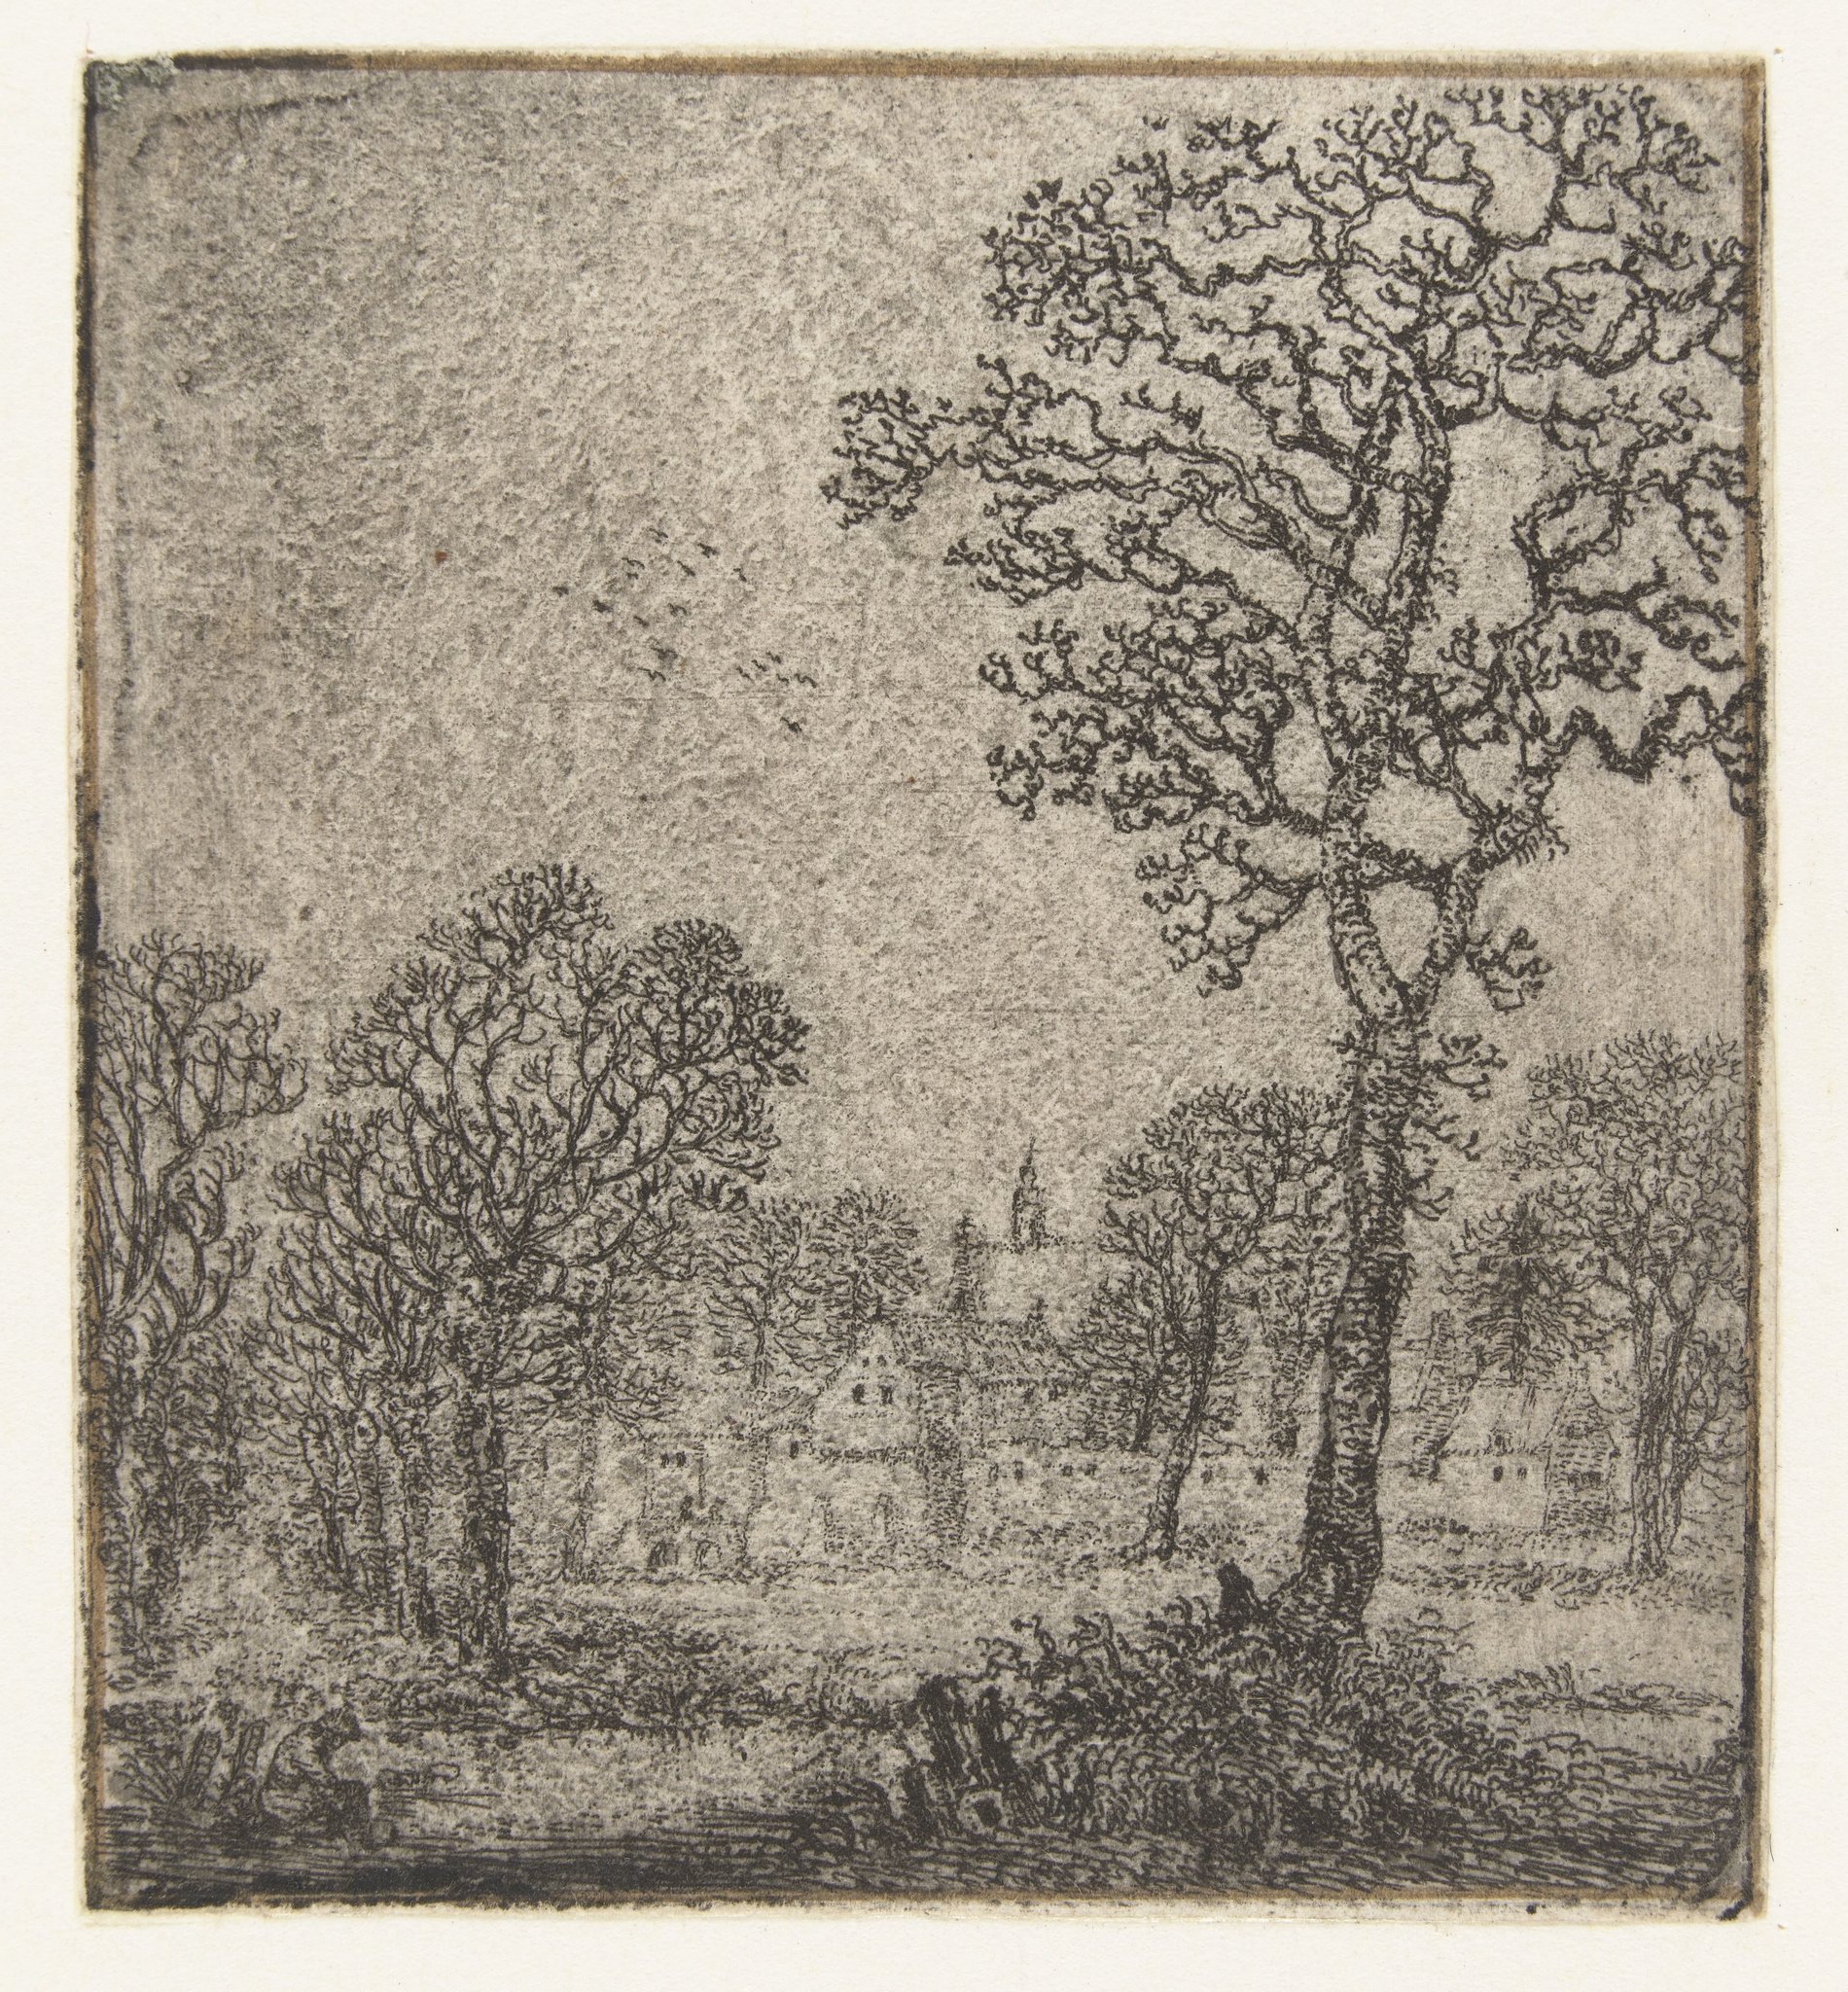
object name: print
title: Winterlandschap met gezicht op een dorp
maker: jan van brosterhuyzen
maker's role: draughtsman, print maker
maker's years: 1596-1650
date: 1610-1650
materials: paper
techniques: etching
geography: netherlands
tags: prospect of village, silhouette of village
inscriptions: collector's mark: Lugt 2228a